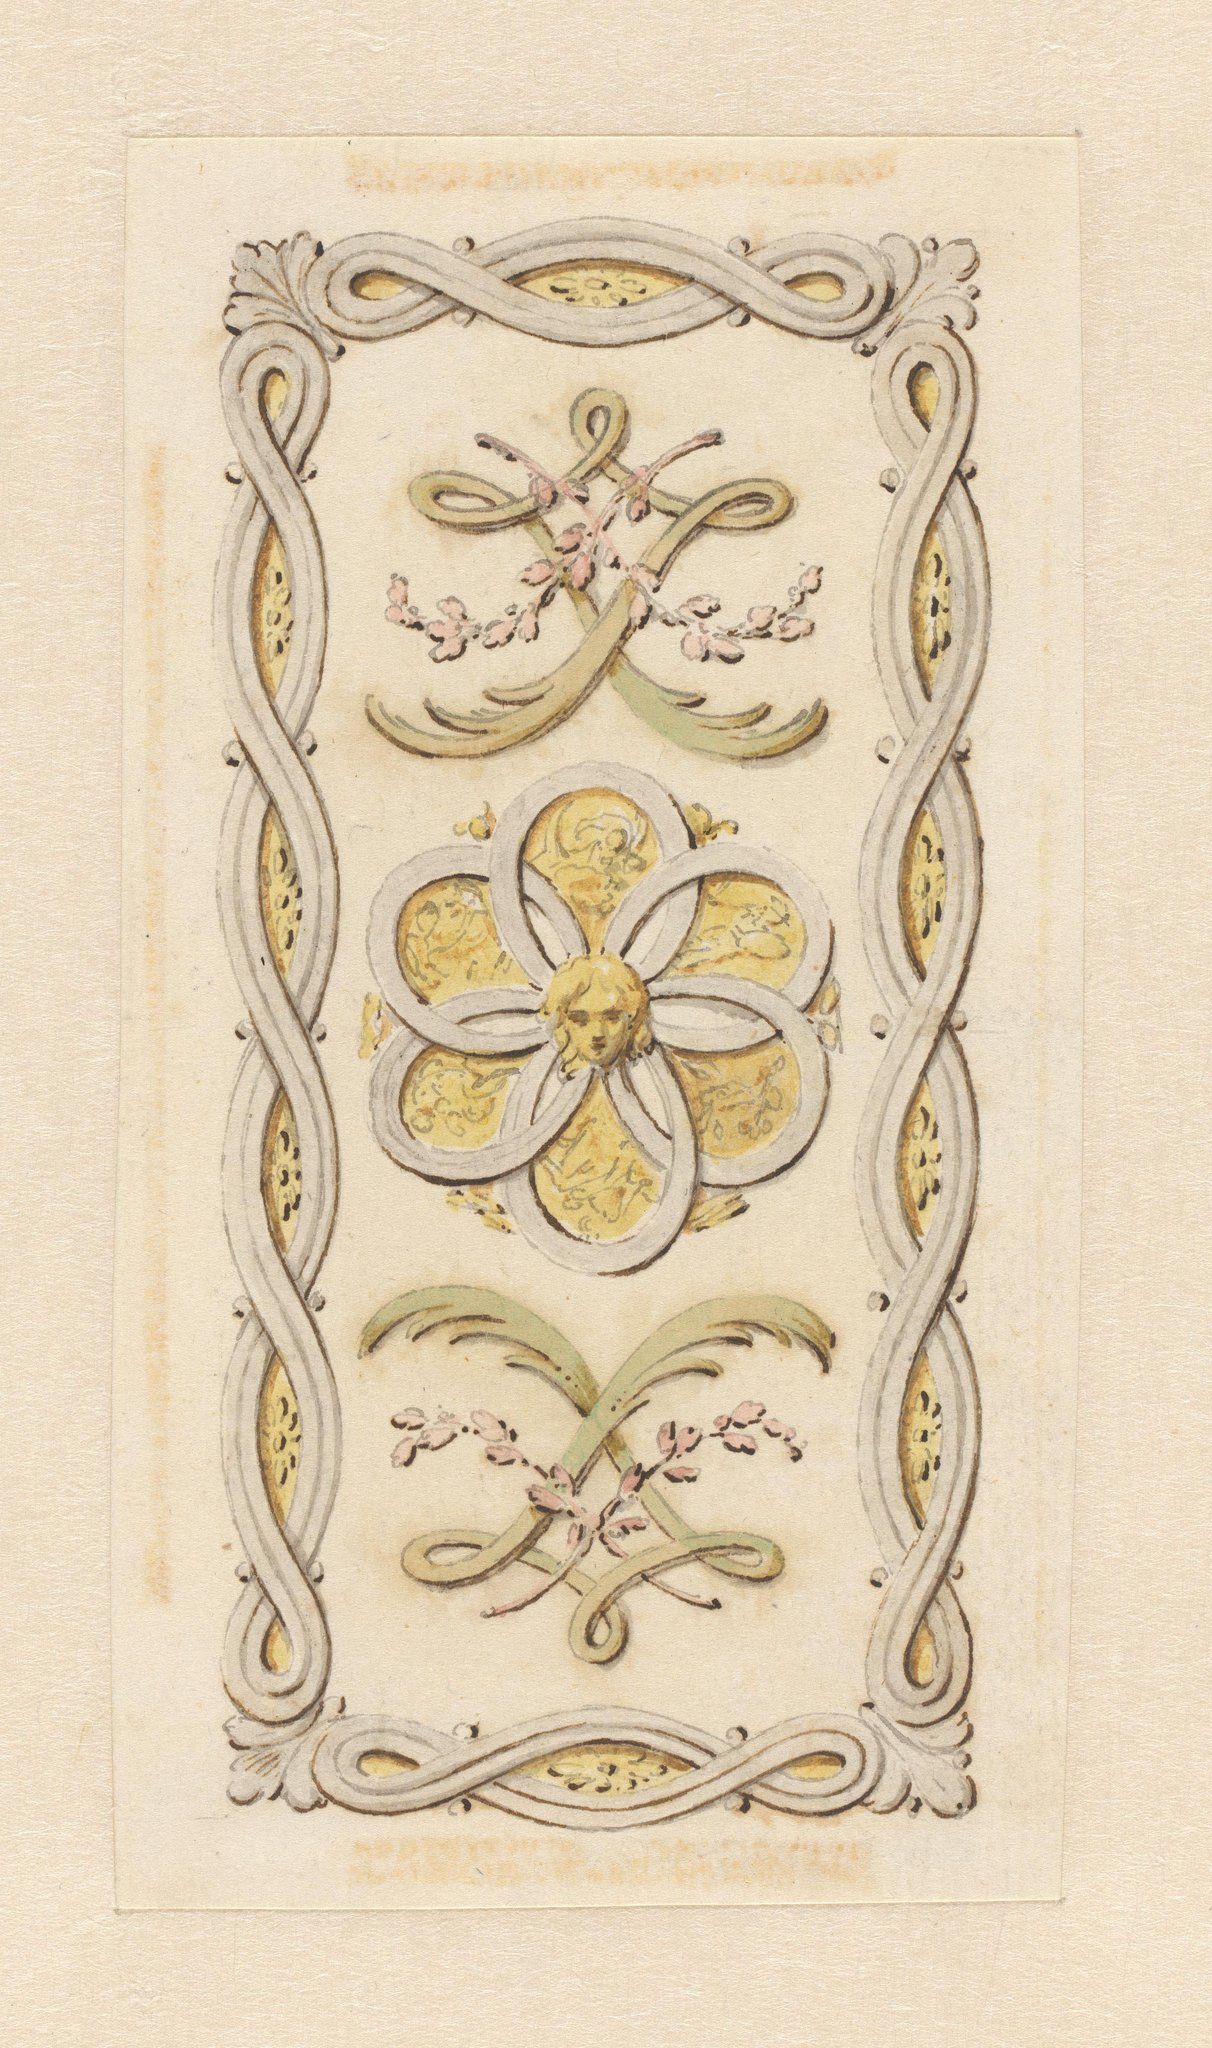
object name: design drawing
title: Souvenir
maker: Anonymous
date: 1750-1760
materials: graphite, ink, paper, watercolor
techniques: aquarelle, pen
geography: paris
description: De voorkant van een souvenir met twee maal het monogram van een dubbele L, voor Lodewijk XV (?).